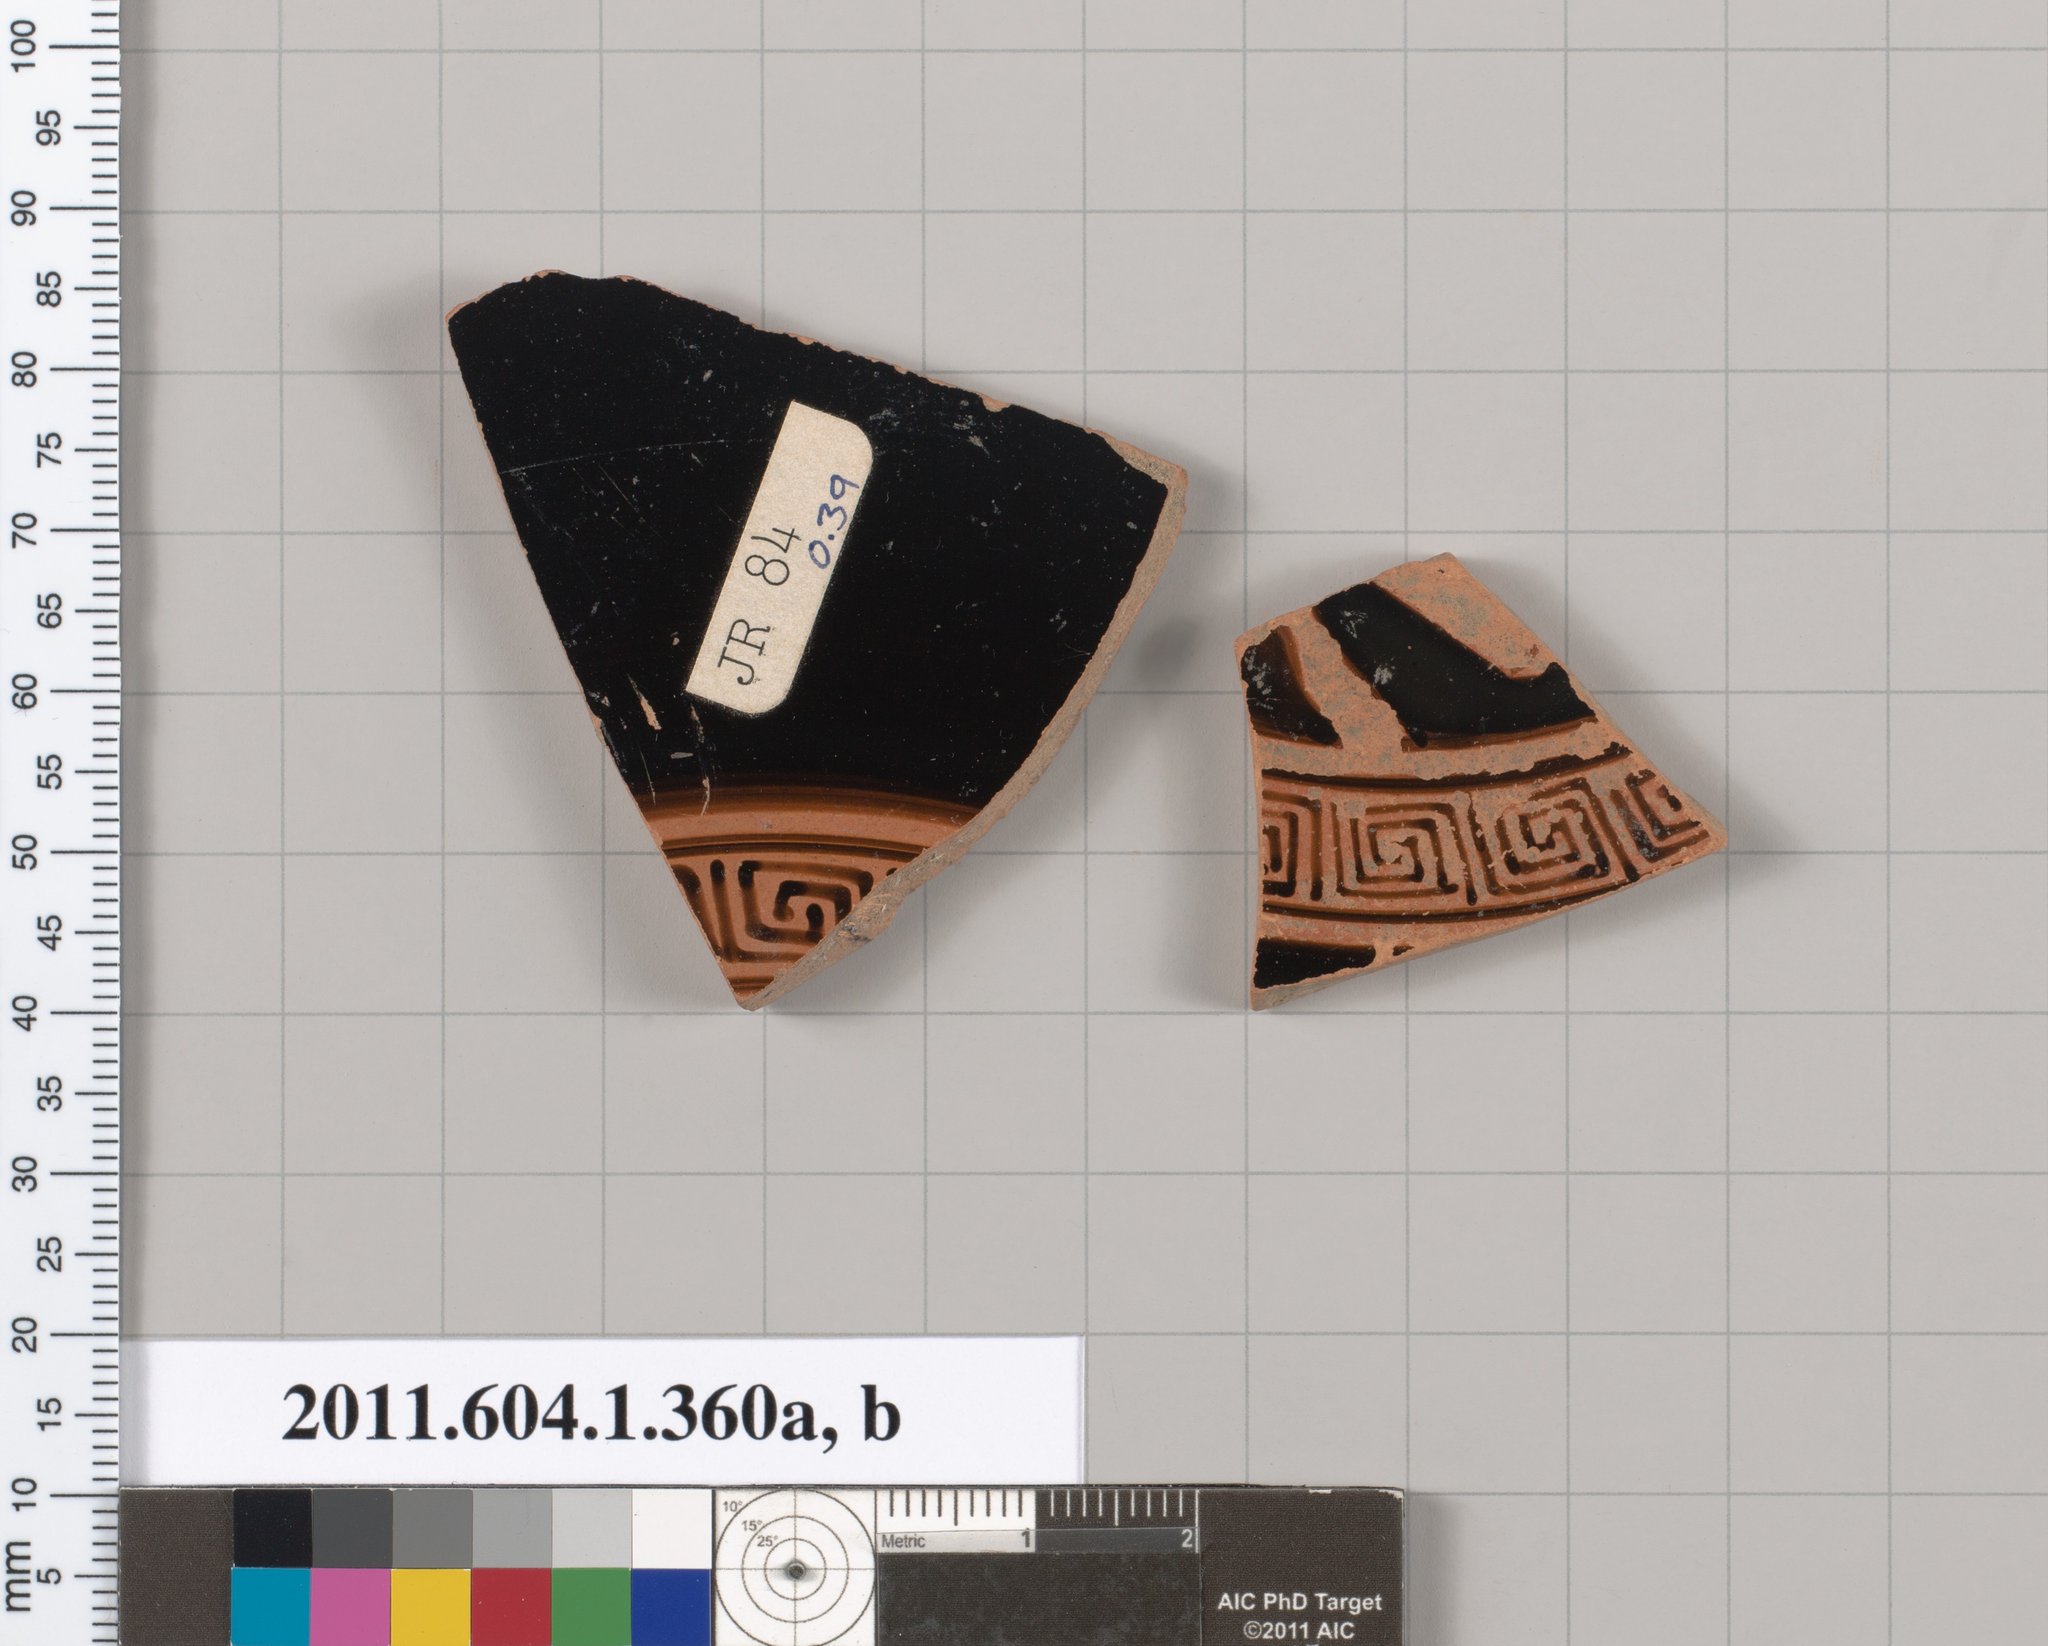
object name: kylix fragment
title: Terracotta fragments of kylikes (drinking cups)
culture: greek, attic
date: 475-451 BCE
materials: terracotta